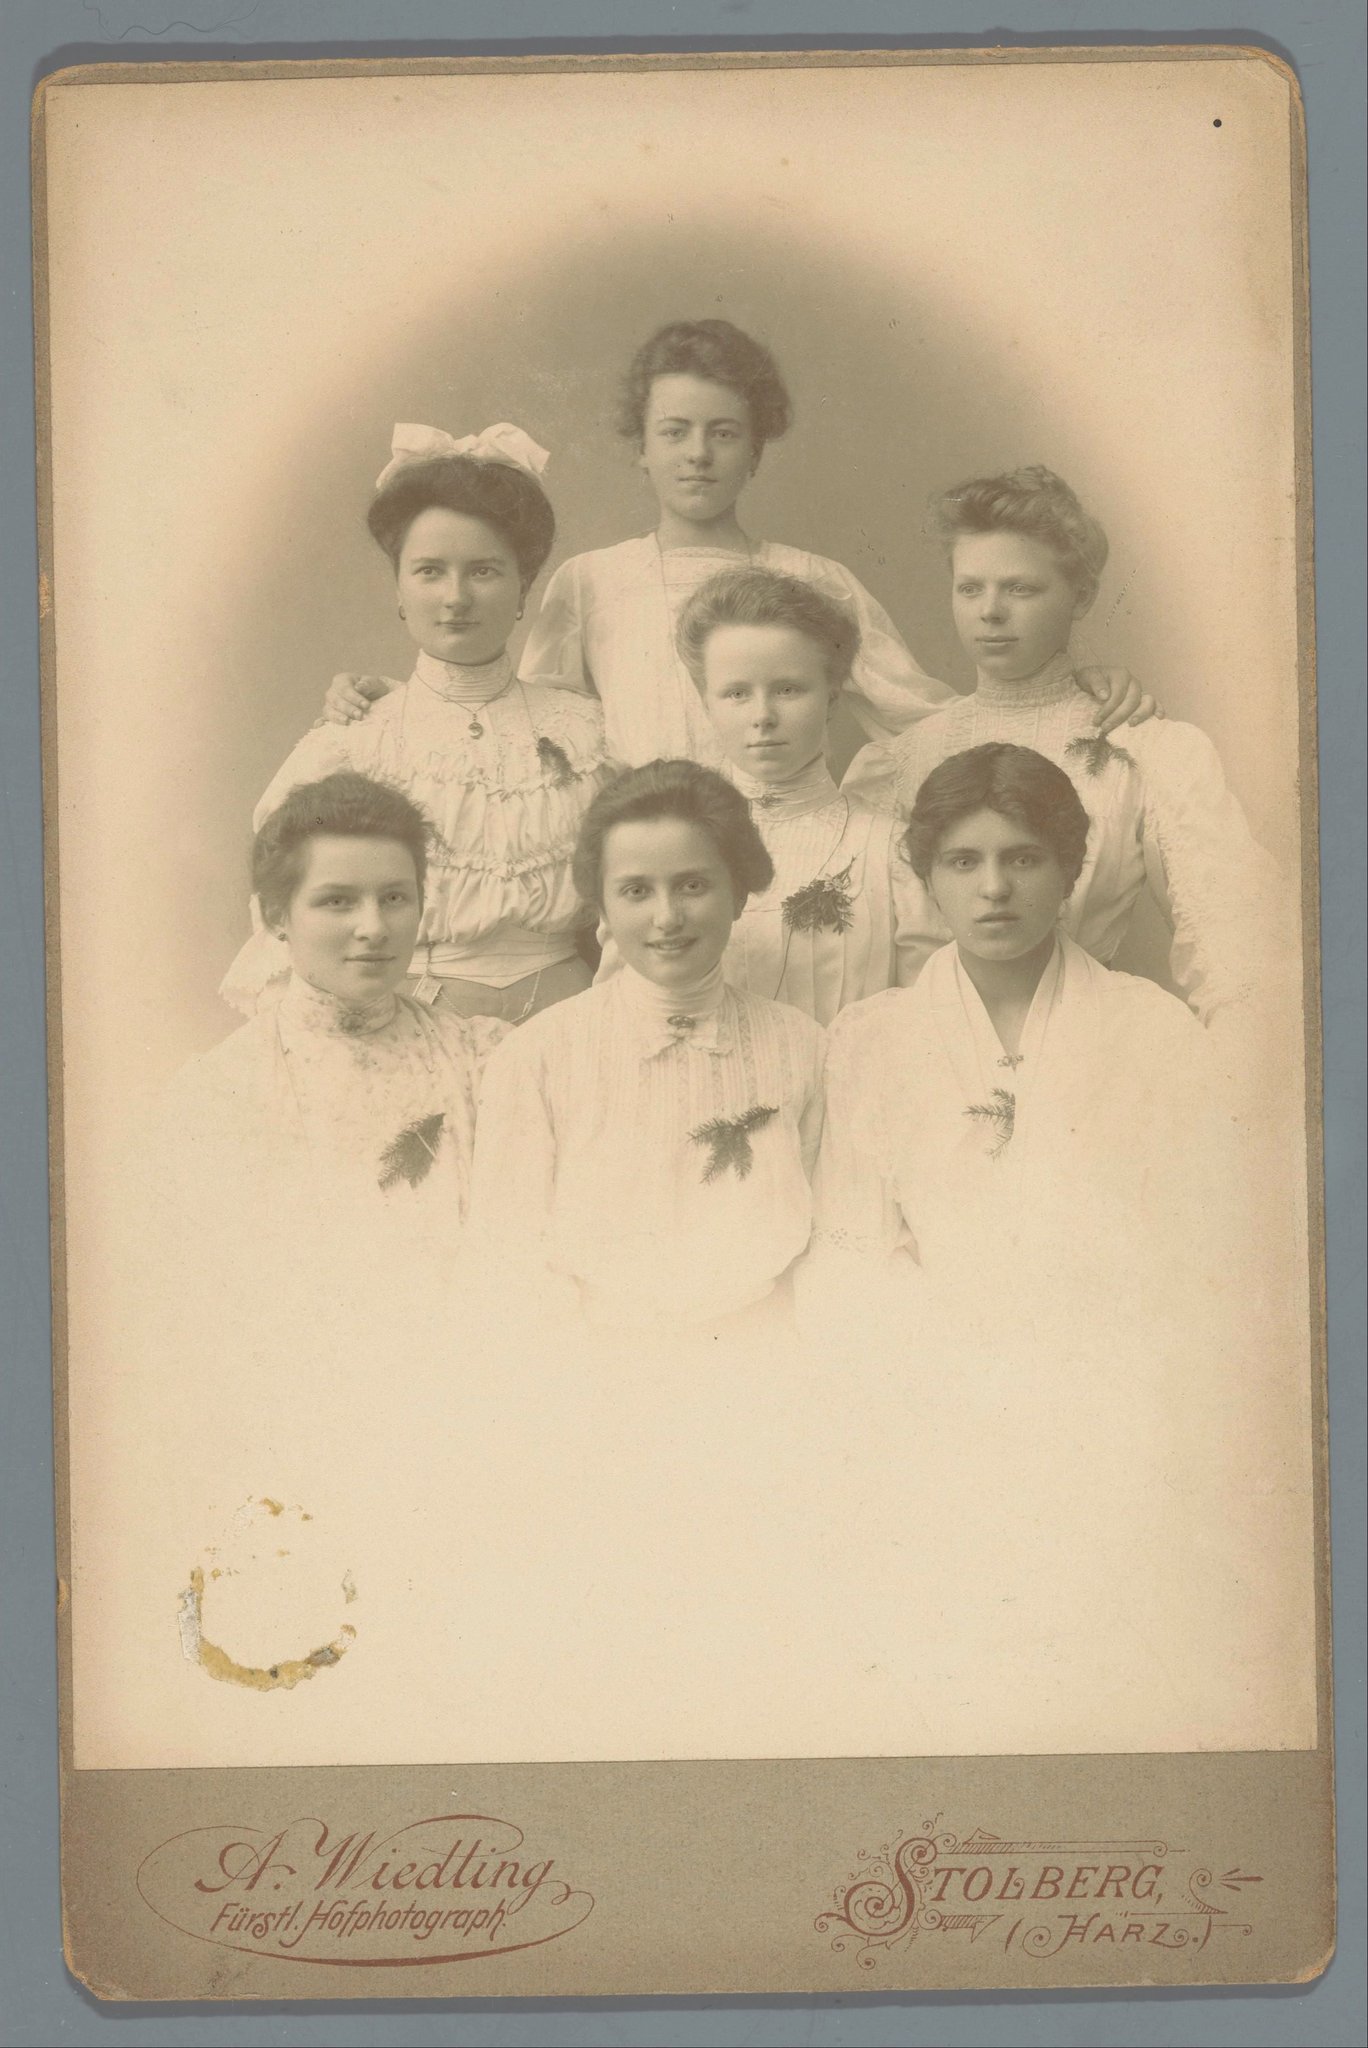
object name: cabinet photograph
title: Groepsportret van zeven onbekende vrouwen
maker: anton wiedling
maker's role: fotograaf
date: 1900-1920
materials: cardboard, photographic support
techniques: albumen print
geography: stolberg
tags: anonymous historical persons portrayed in a group, in a group-portrait